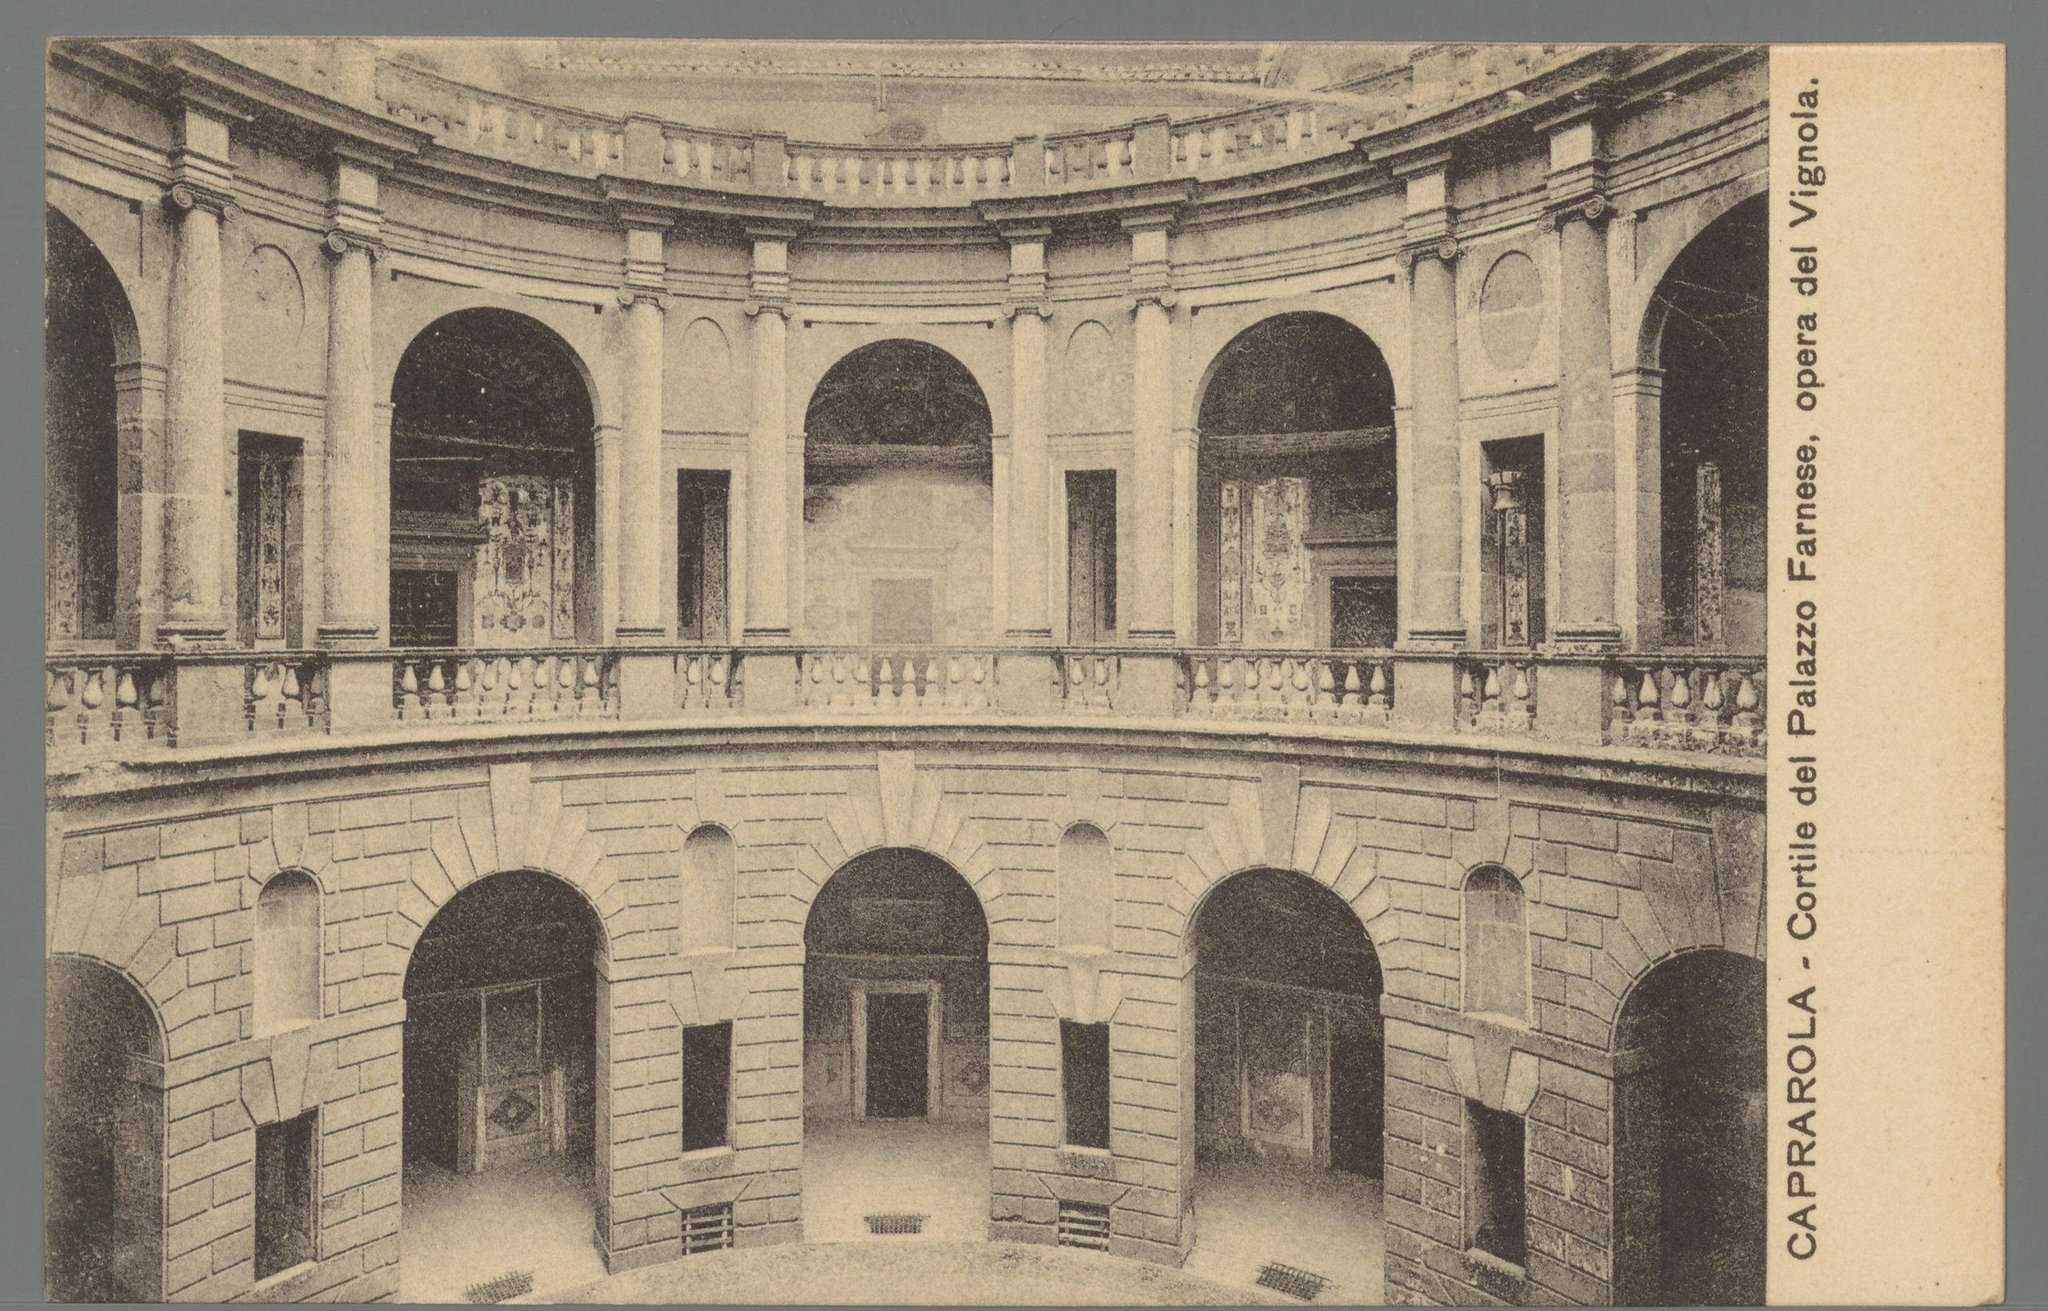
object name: ansichtkaart, prentbriefkaart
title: Caprarola. Cortile del Palazzo Farnese, opera del Vignola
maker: Anonymous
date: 1906-1930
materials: cardboard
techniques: photograph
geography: caprarola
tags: palace, interior ~ representation of a building